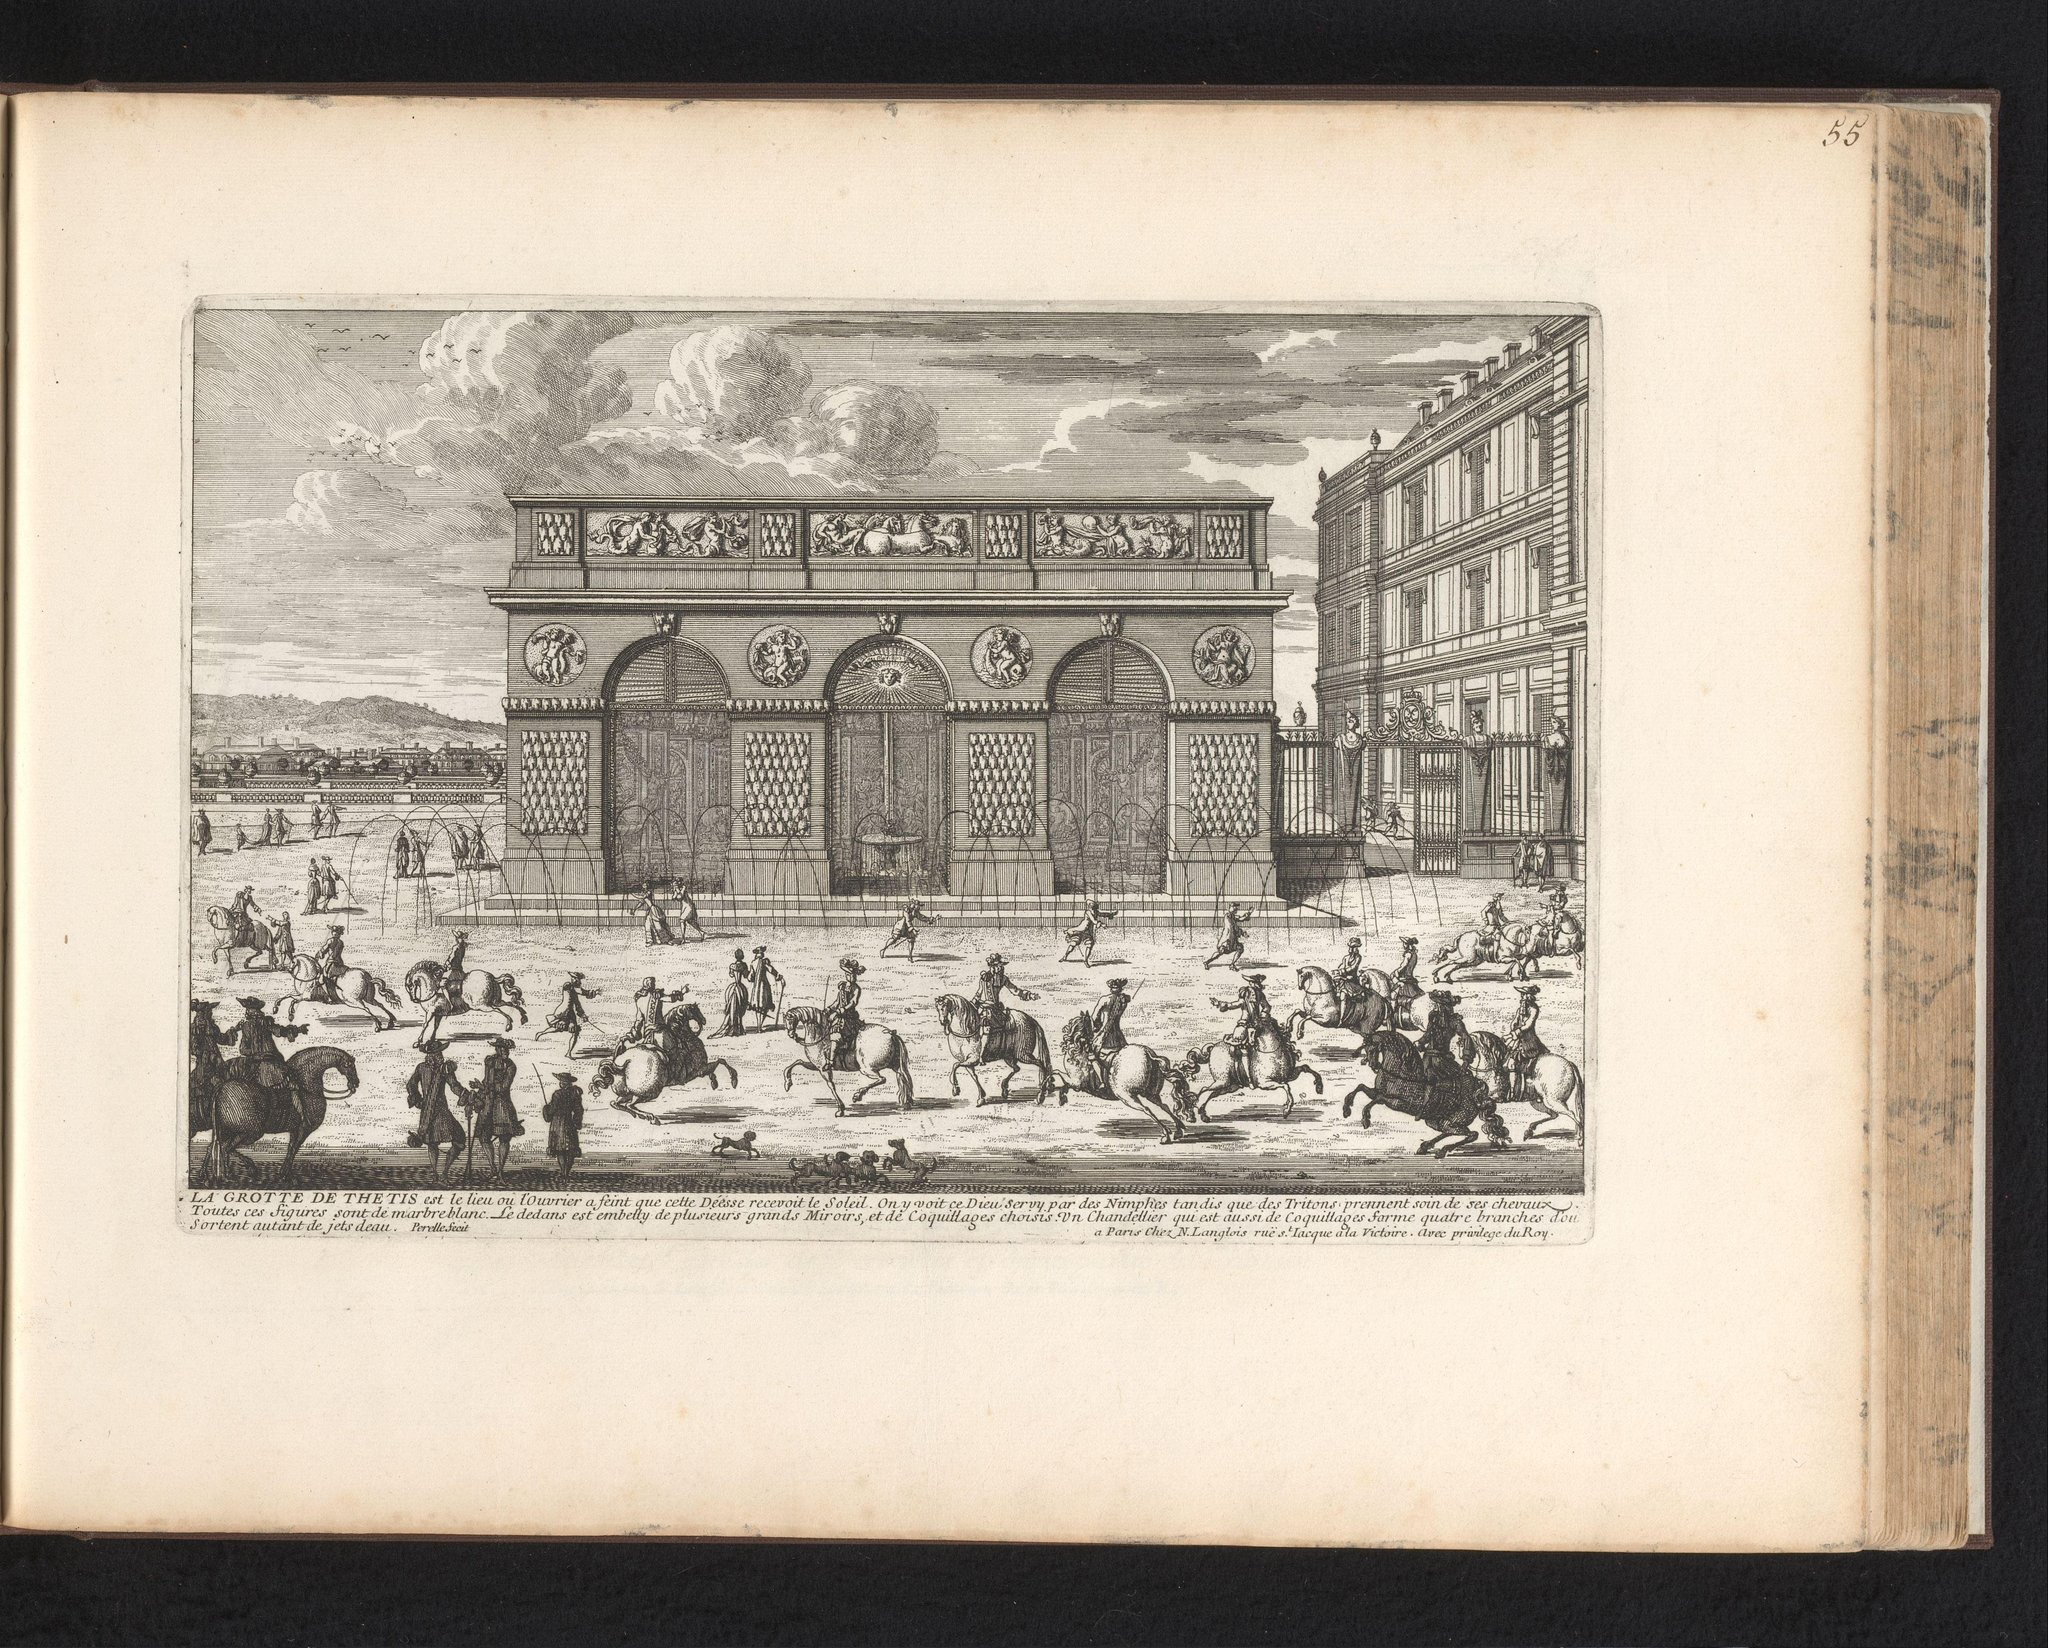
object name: album leaf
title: Gezicht op de grot van Thetis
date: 1664-1695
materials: paper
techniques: etching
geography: paris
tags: garden fountain, (story of) thetis; 'thethi, ninfa del mare' (ripa), french or architectonic garden; formal garden, landscape with tower or castle, artificial grotto in garden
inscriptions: collector's mark: Lugt 2228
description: Prenten met het signatuur 'Perelle' kunnen zowel door vader Gabriel als door zonen Nicolas en Adam gemaakt zijn. De uitgevers vader en zoon Nicolas Langlois worden allebei vermeld als N. Langlois op hetzelfde adres.